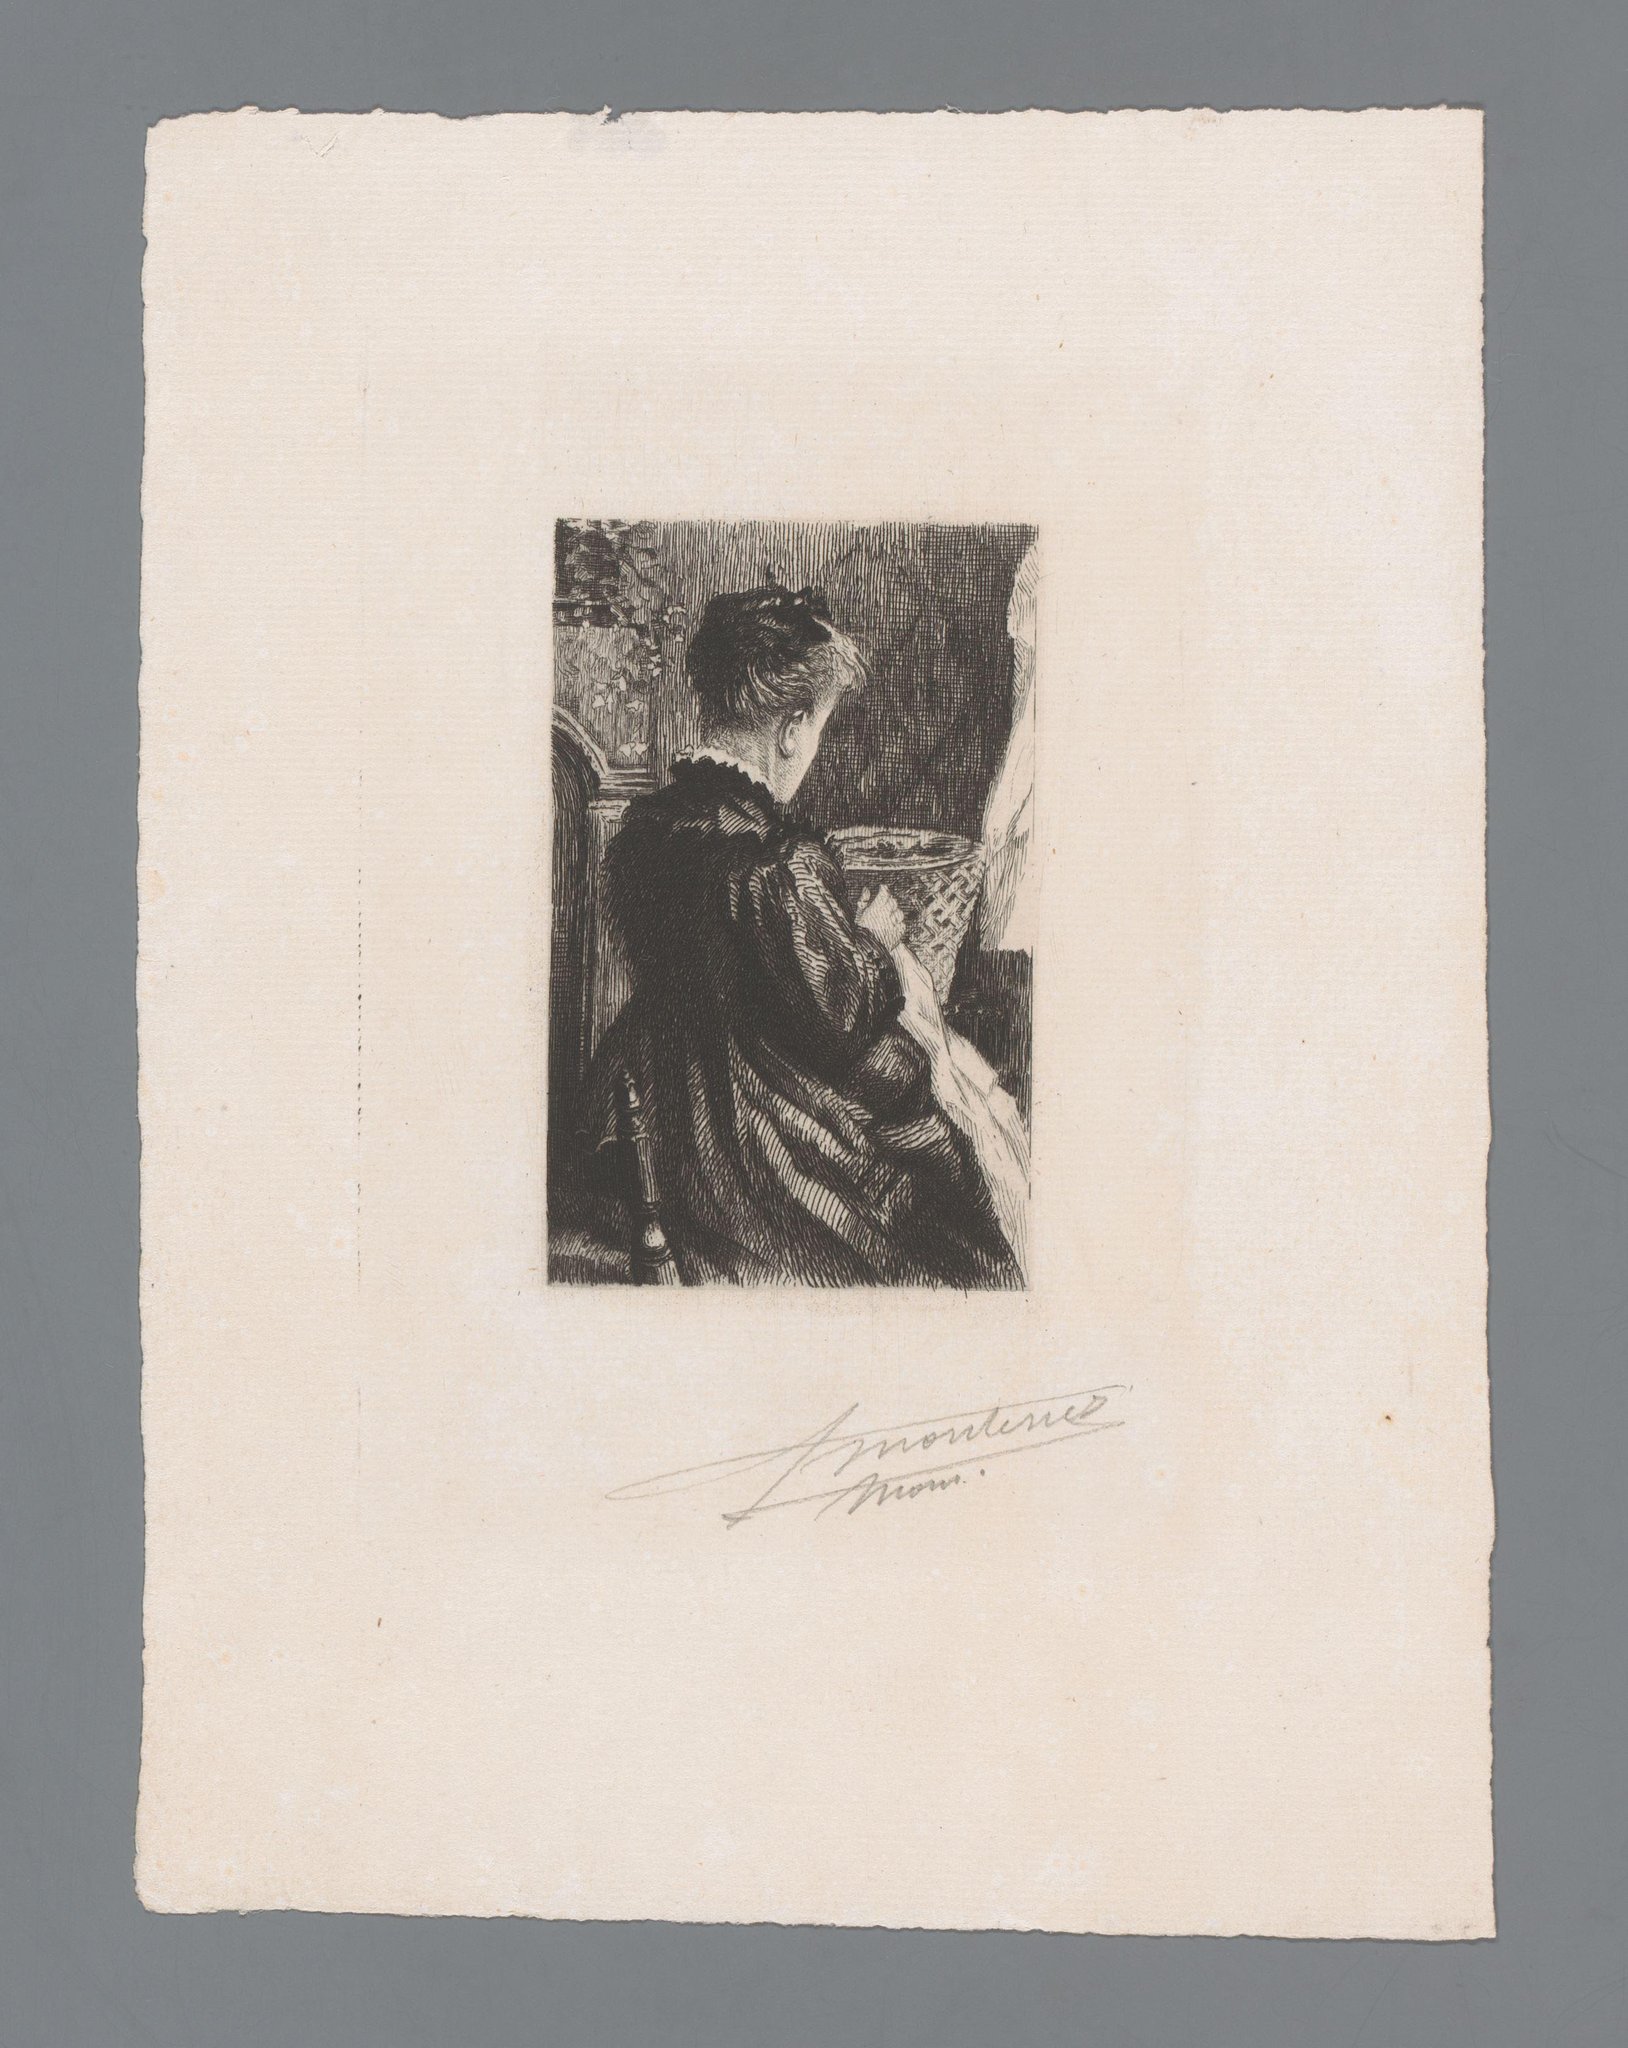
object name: print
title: Vrouw met naaiwerk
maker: georges montenez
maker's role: print maker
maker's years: 1873-1930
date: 1883-1913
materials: paper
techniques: etching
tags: head-gear and clothing for the upper part of the body, adult woman